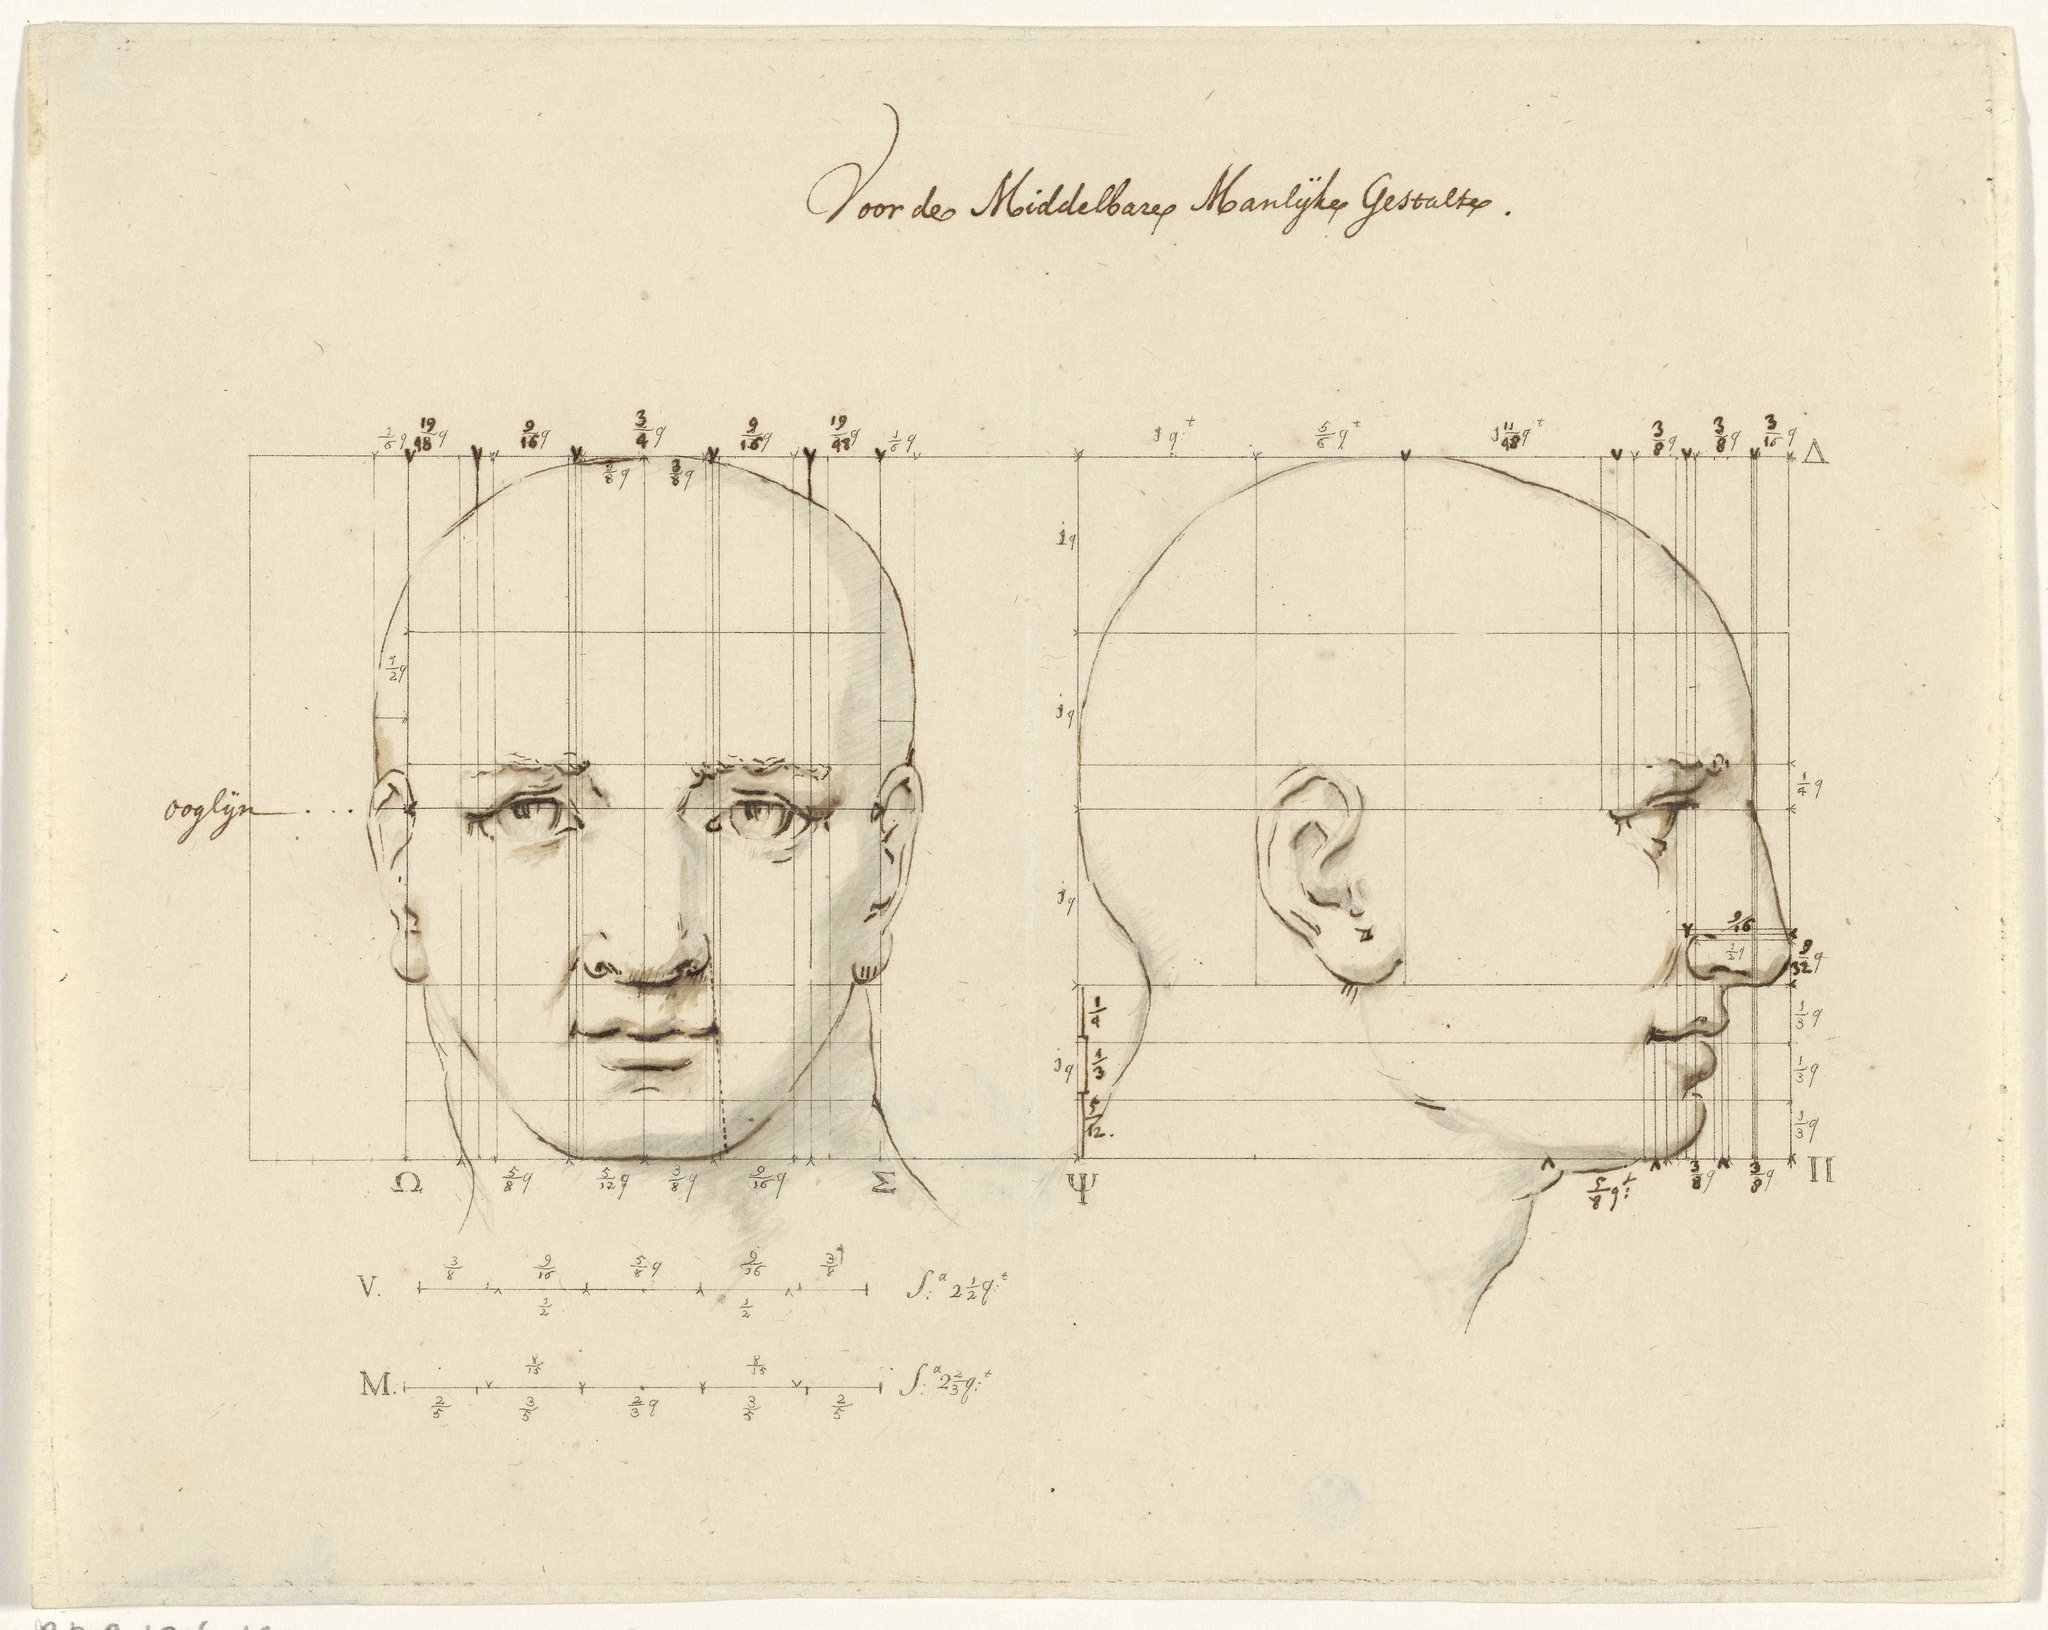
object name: print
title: Studie van een mannenhoofd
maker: lambert ten kate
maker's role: print maker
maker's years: 1674-1731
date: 1684-1731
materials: ink, paper, pencil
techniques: etching, pen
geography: amsterdam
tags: head (human) (+ front view), head (human) (+ sideview, profile)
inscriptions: collector's mark: Lugt 2228, collector's mark: Lugt 1337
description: Studies van een mannenhoofd in de juiste verhoudingen. Linksonder staan twee schaalverdelingen; voor de bovenste staat een V en voor de onderste een M.